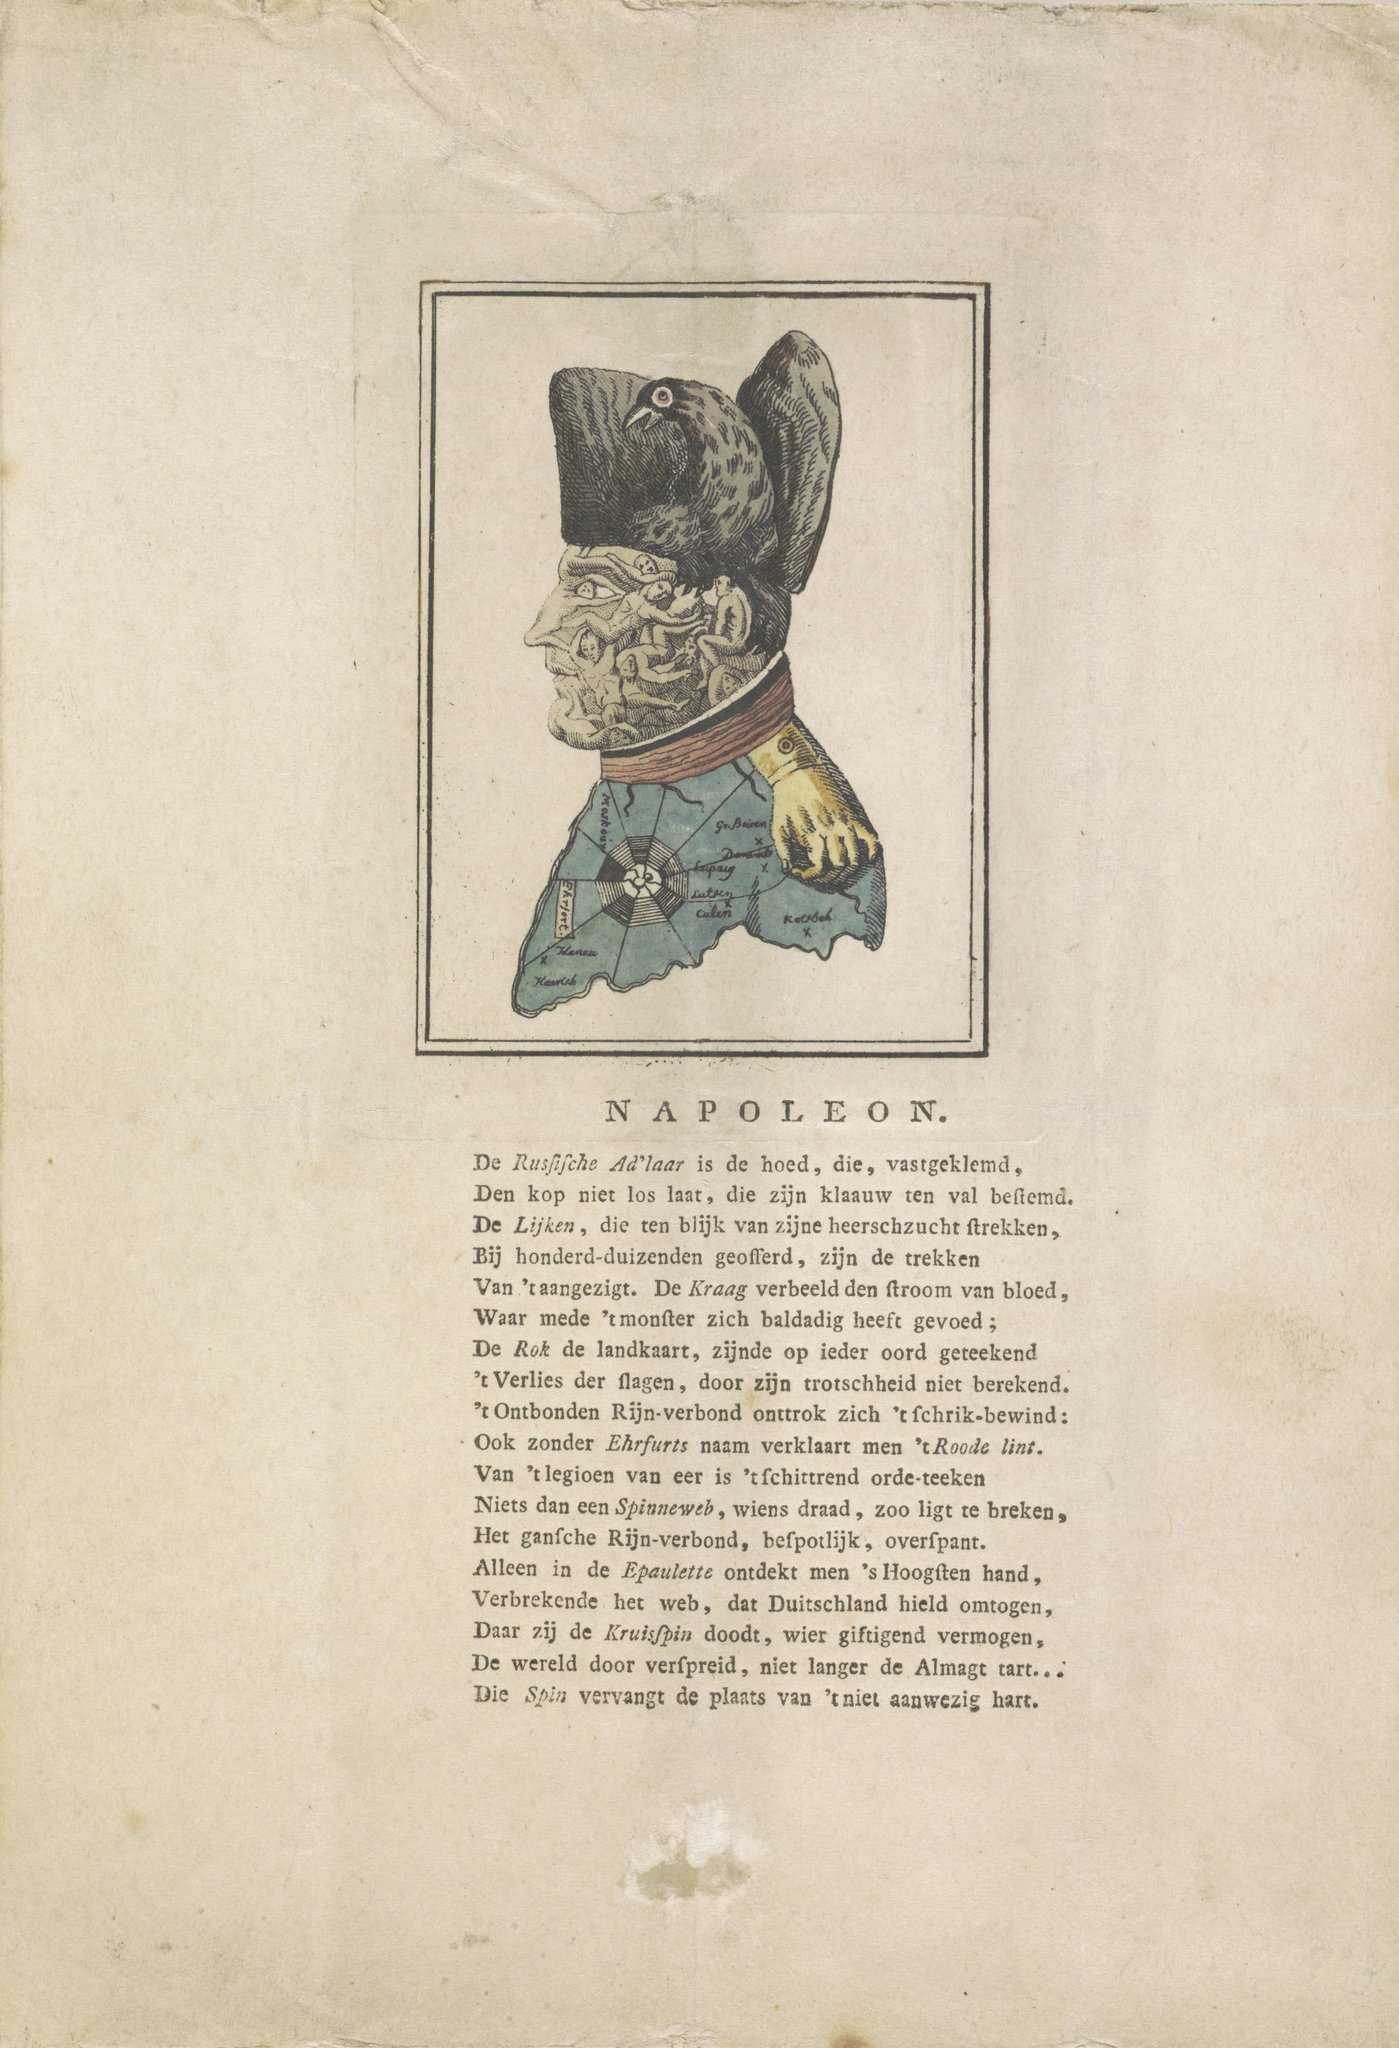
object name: cartoon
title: Napoleon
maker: Anonymous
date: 1813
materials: paper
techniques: etching, hand coloring, letterpress printing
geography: netherlands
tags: napoleon i (emperor of the french), political caricatures and satires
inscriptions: collector's mark: Lugt 2228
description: Spotprent op Napoleon van 1813 waarbij zijn gezicht is opgebouwd uit de lijken van zijn slachtoffers, zijn hoed is de Pruisische adelaar, zijn epaulet is een grijpende hand. De kraag is een rivier van bloed, zijn jas het slagveld van Europa en het ordeteken van het Legioen van Eer op zijn borst is een spinnenweb. Op het blad onder de plaat een vers van achttien regels.